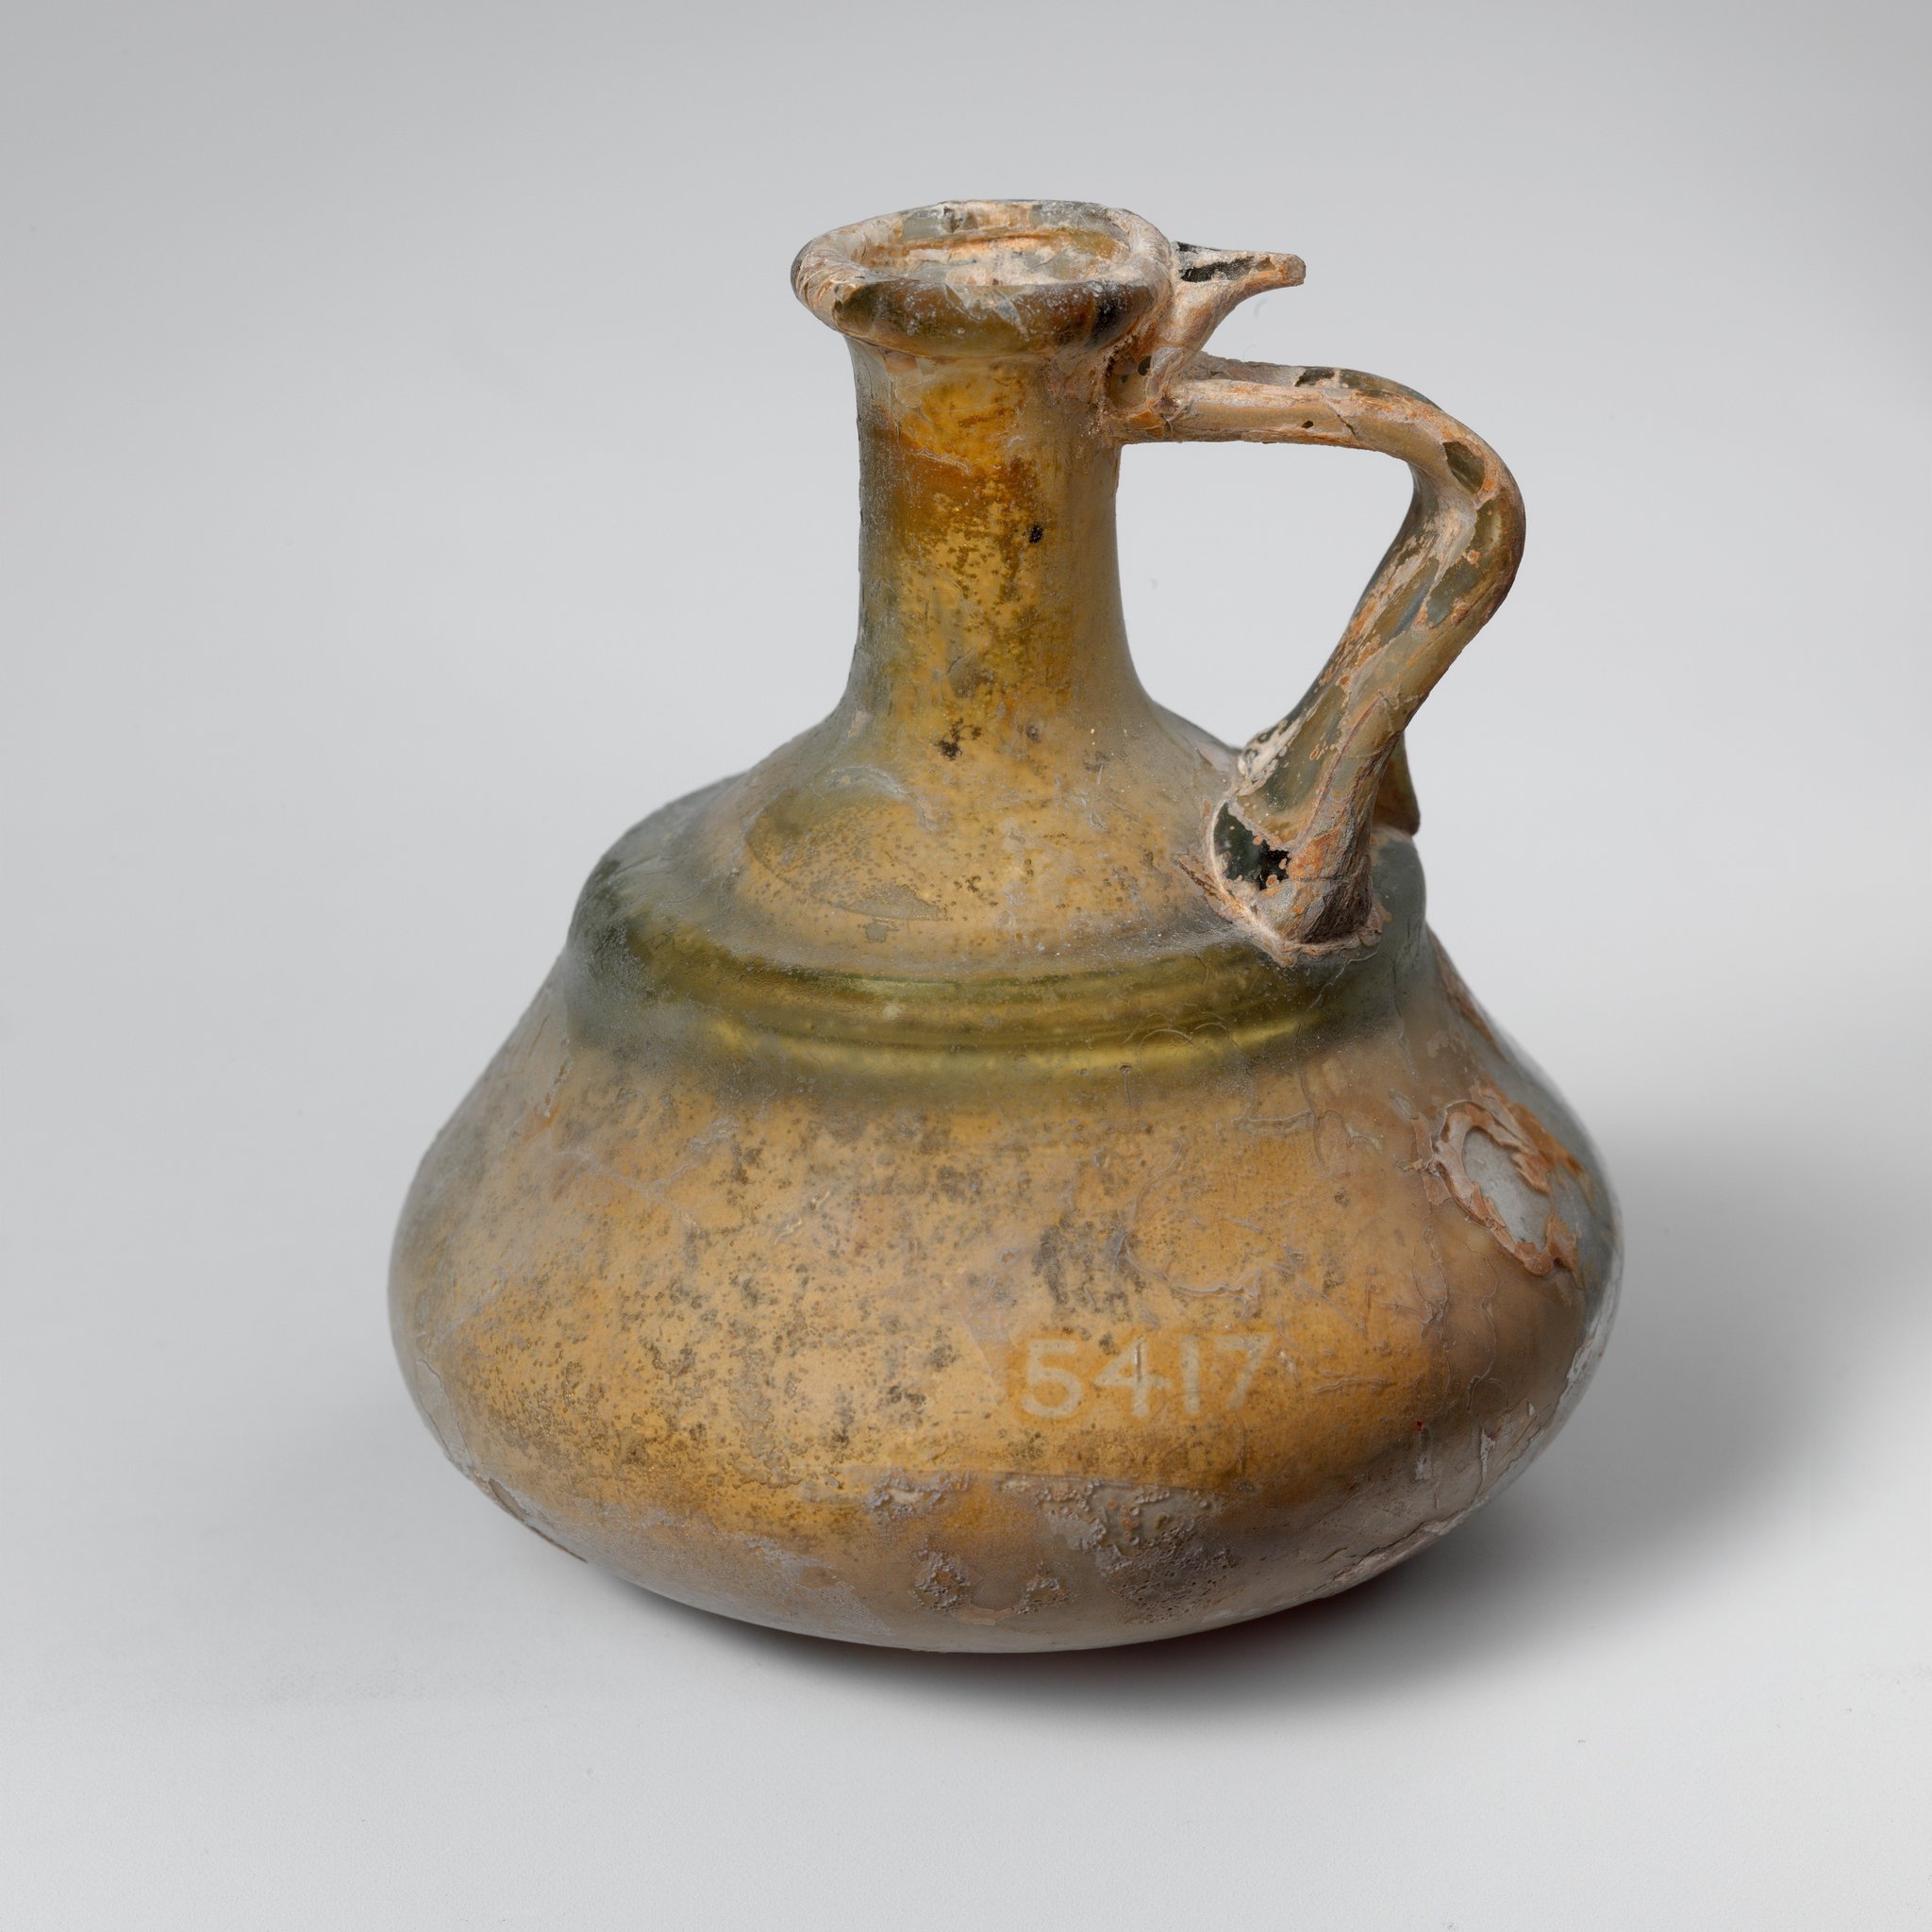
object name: jug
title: Glass jug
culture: roman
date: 34-200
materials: glass